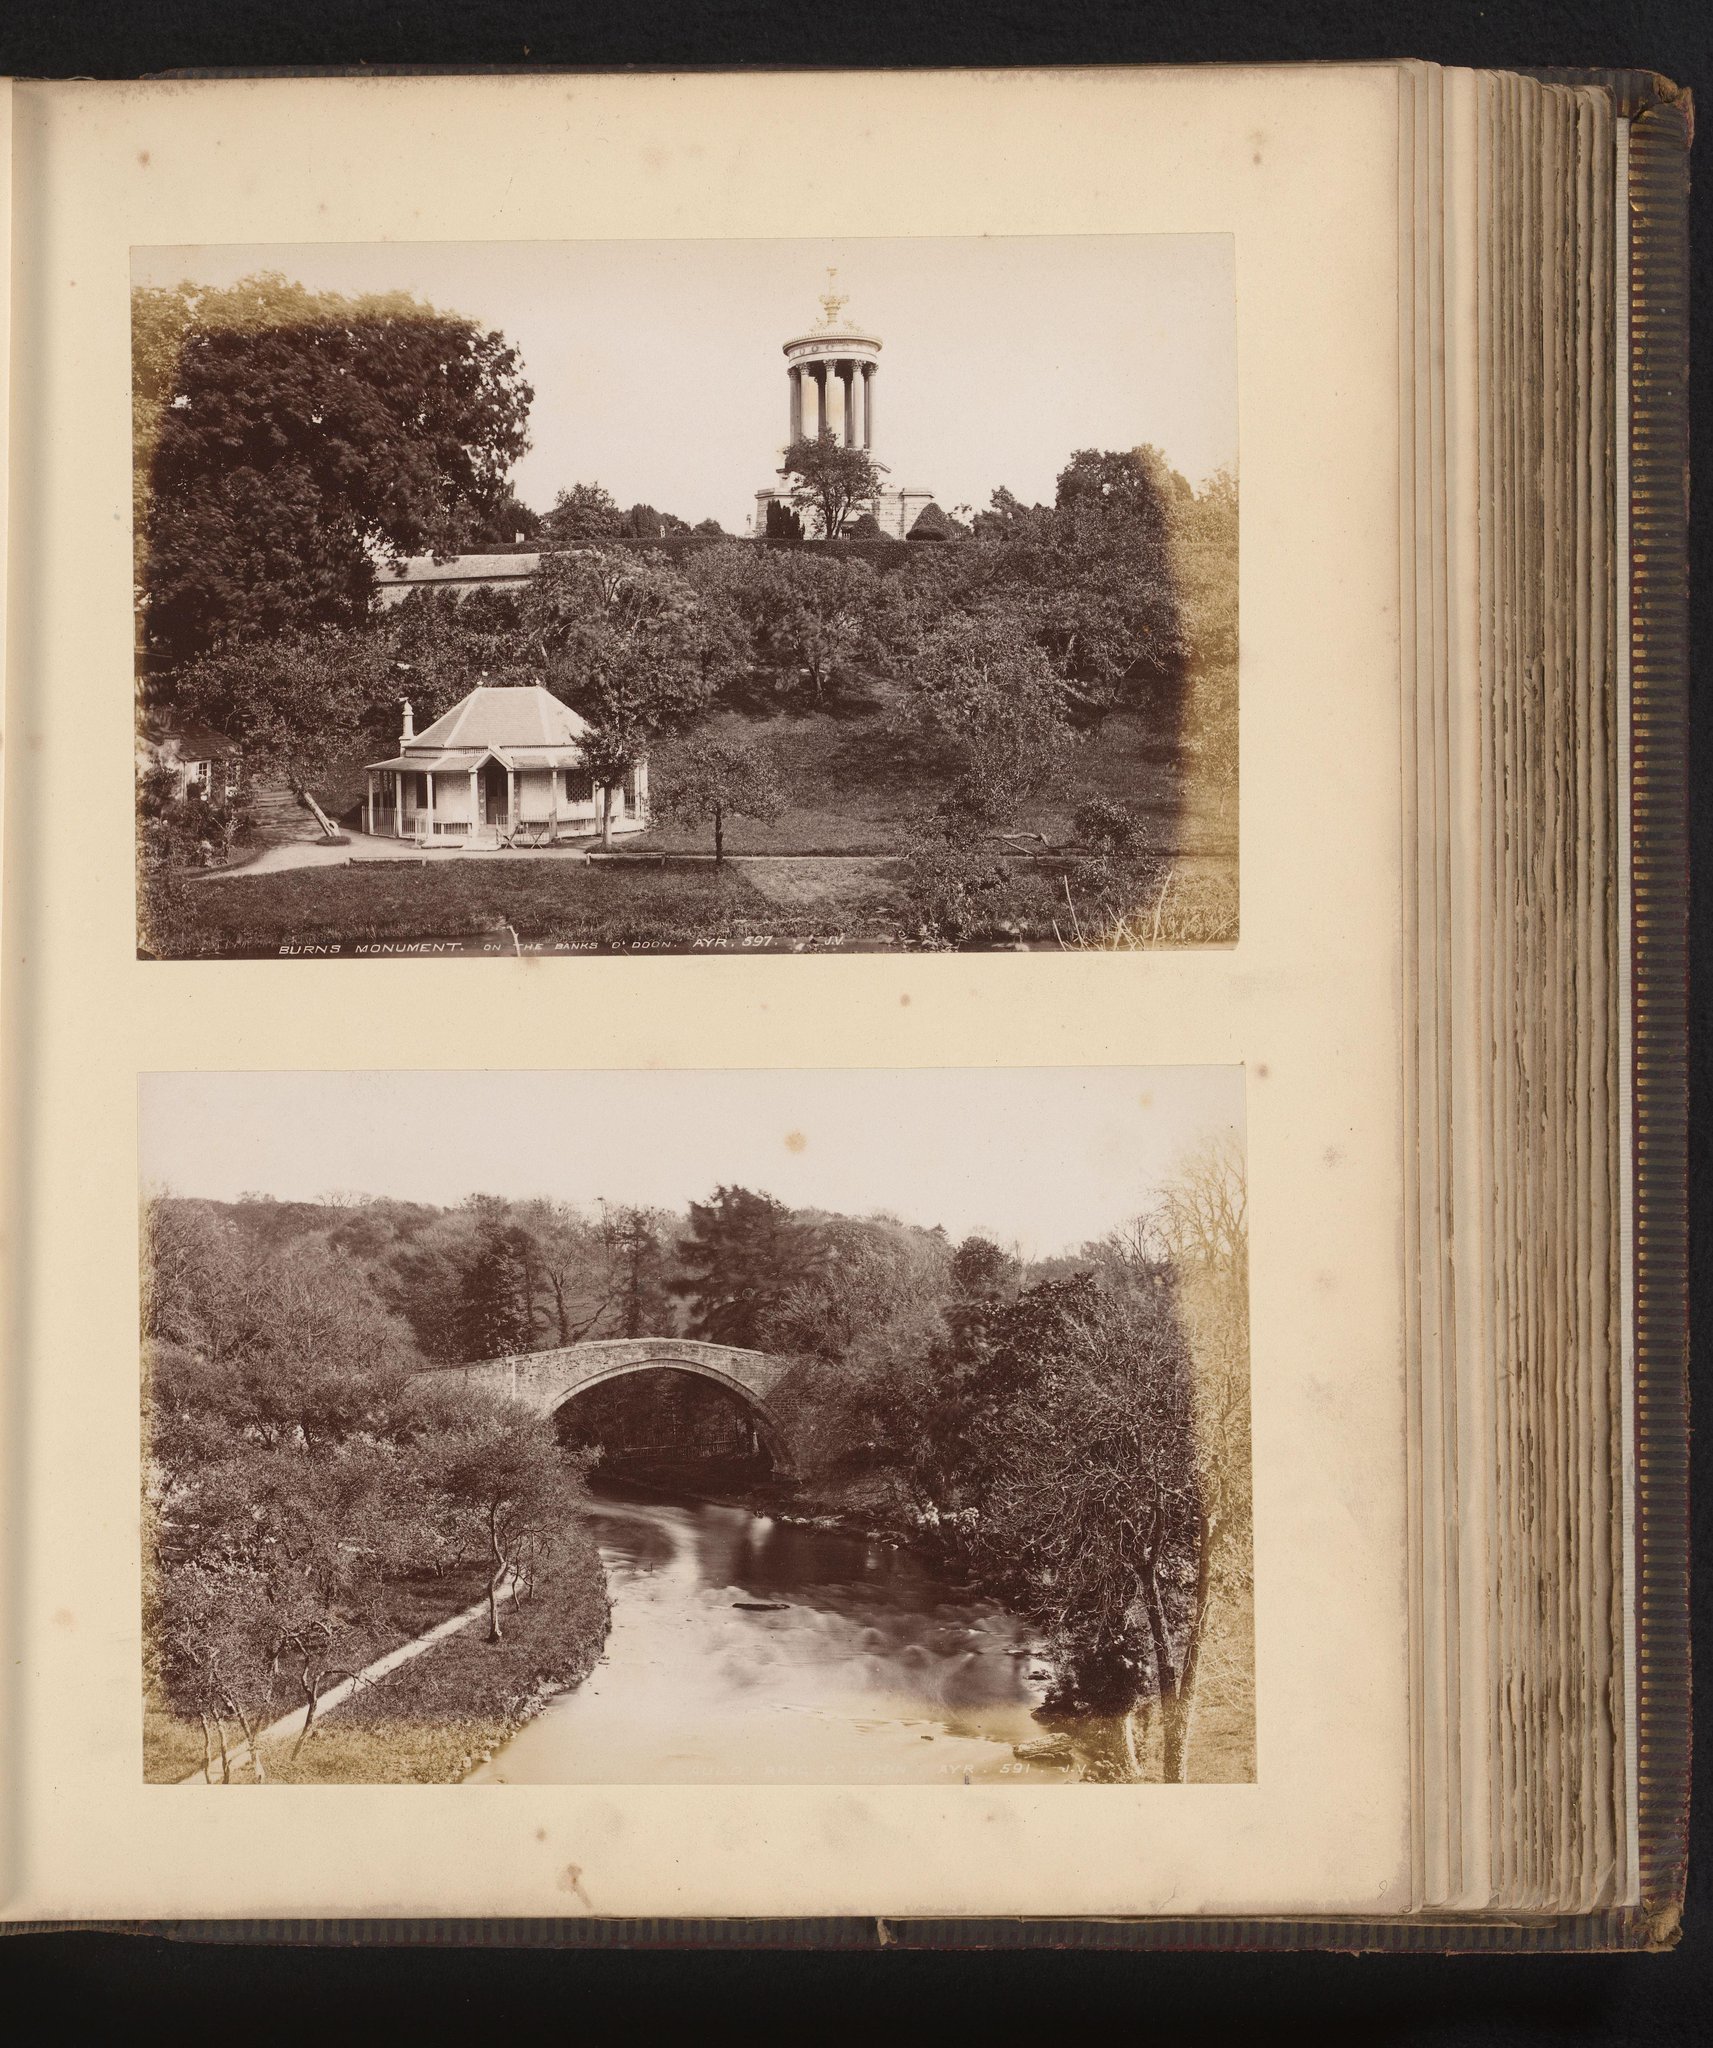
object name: photograph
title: Auld Brig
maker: Anonymous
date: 1875-1885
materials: photographic support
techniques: albumen print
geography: brig o' doon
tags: monument, statue, bridge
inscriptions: number: ‘597, J.V.’, number: ‘591, J.V.’